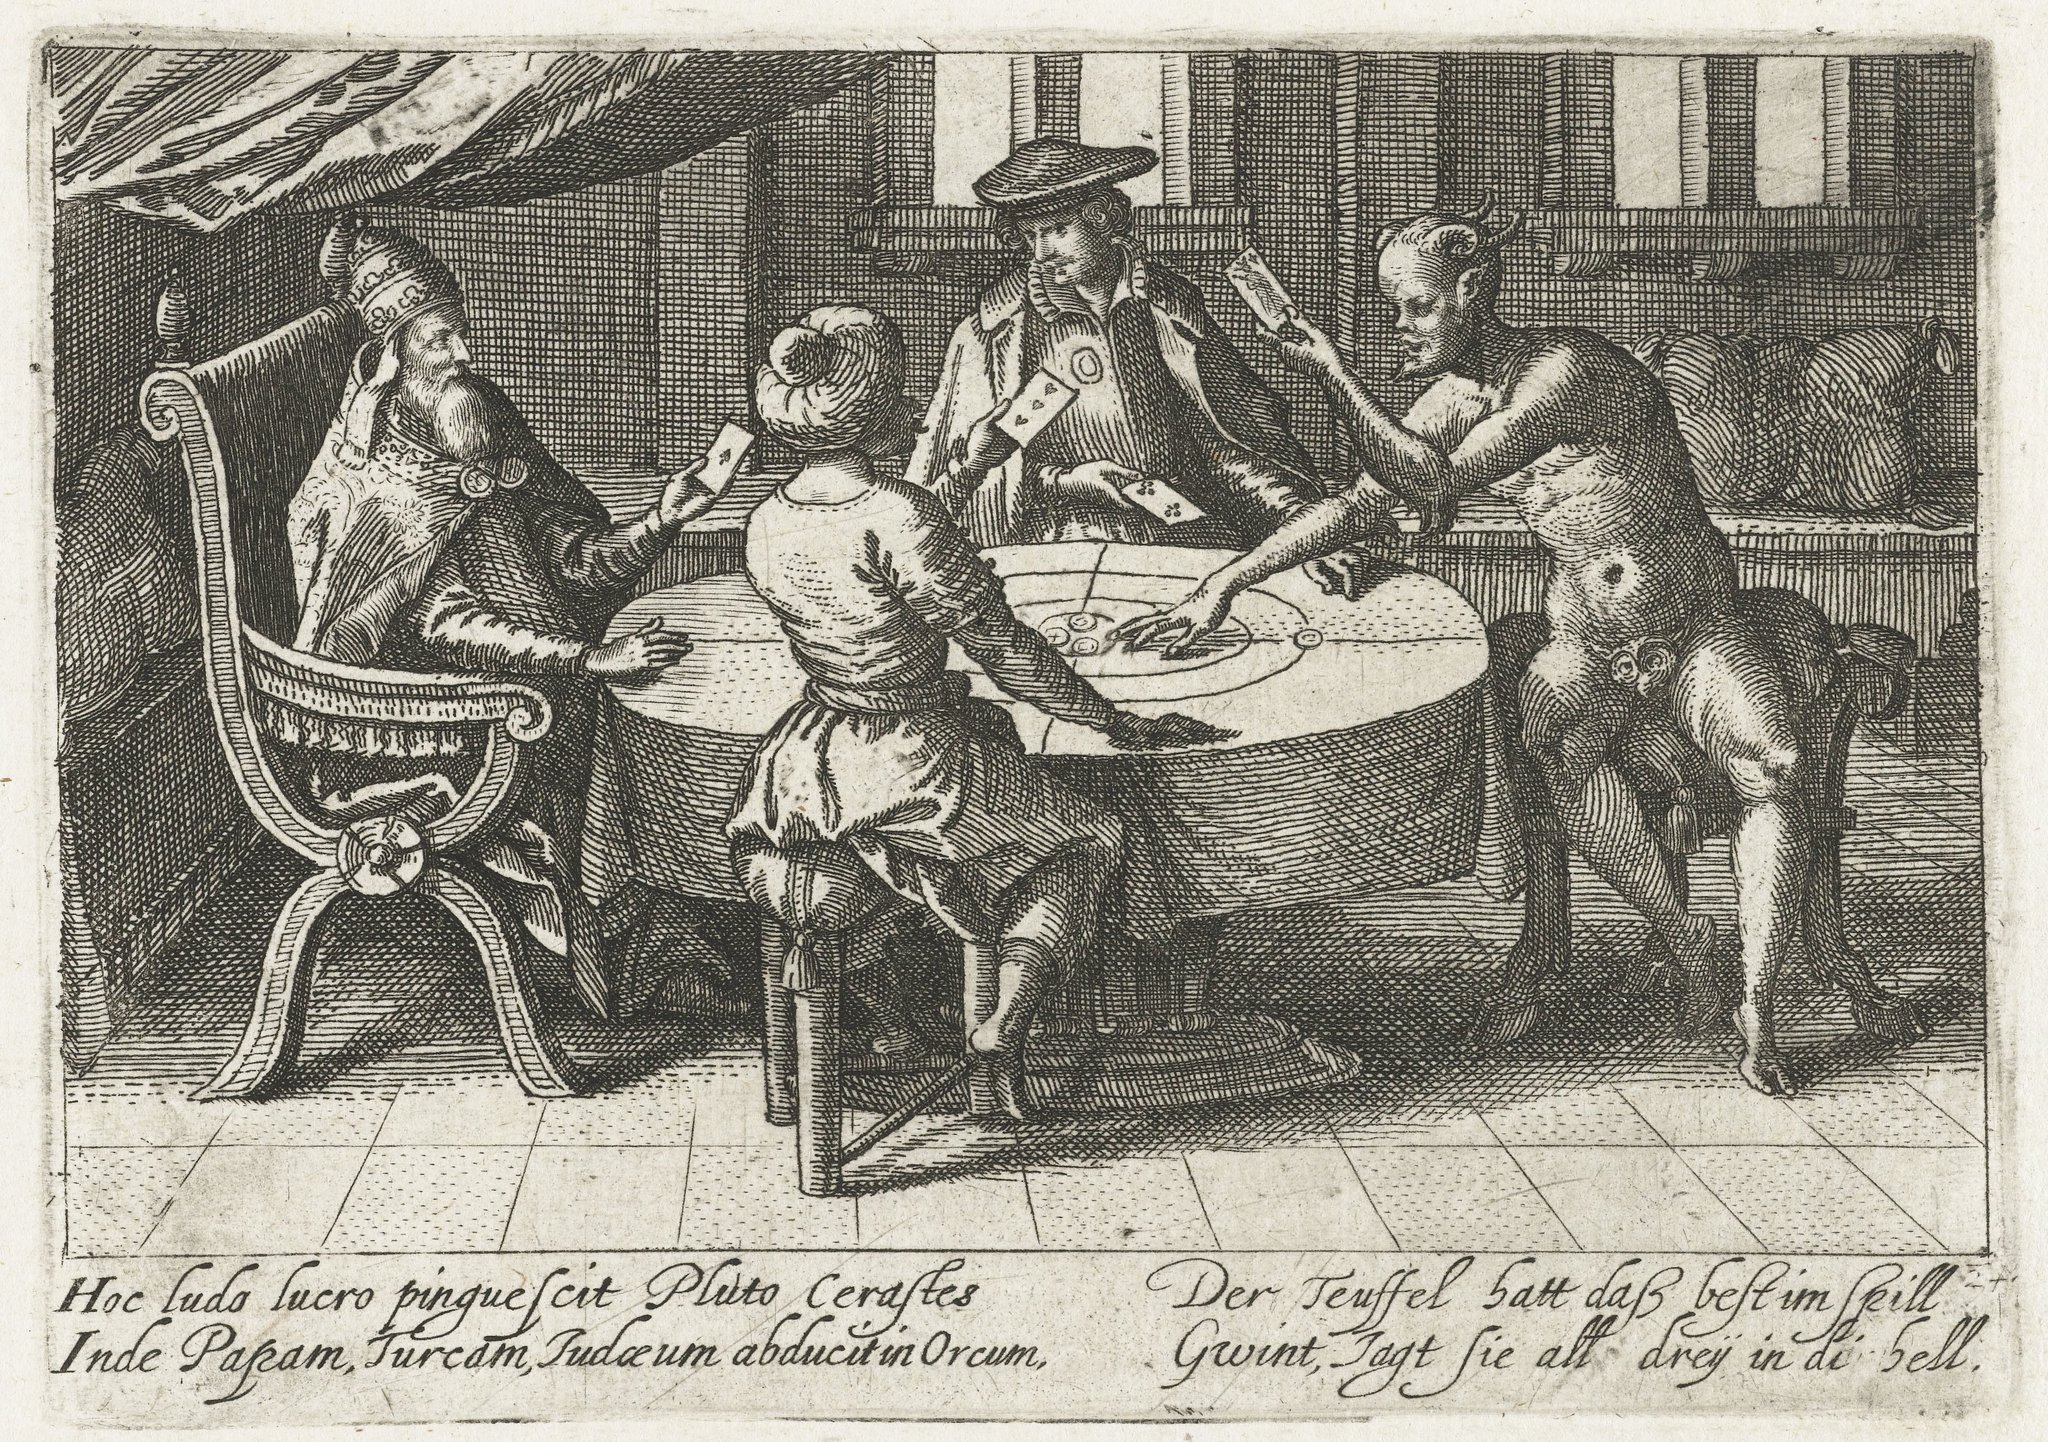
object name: print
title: Religieuze leiders kaarten met de Duivel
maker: jacob van der heyden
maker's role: draughtsman, print maker, publisher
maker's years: 1573-1645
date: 1608-1618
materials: paper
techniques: engraving, etching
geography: straatsburg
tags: priest ~ islam, mohammedanism, 'album amicorum', 'stammbuch', morality, card games, human-shaped devil, pope, priests ~ hierarchy of priests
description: Deze serie, getiteld ‘Pugillus facetiarum iconographicarum in studiosorum (…)’, bestond vermoedelijk uit 36 of meer prenten. Van deze serie zijn in ieder geval twee uitgaven bekend, uit 1608 en 1618. De prenten uit deze serie in de collectie van het Rijksmuseum (RP-P-1996-1 t/m RP-P-1996-36) zijn vermoedelijk afkomstig uit verschillende uitgaven, of uit de tweede uitgave. De inhoud van beide uitgaven verschilt, maar om de precieze inhoud van de verschillende uitgaven vast te stellen is meer onderzoek nodig. Er zijn geen volledige exemplaren van de eerste uitgave bekend. Aan de hand van de analyse van een andere serie, ‘Jeucht spieghel’,* die kopieën van ‘Pugillus’ bevat en is uitgegeven in 1610 én de aanwezige exemplaren van prenten uit ‘Pugillus’ in een inmiddels verloren album amicorum uit 1610,** kan in ieder geval van een aantal prenten gesteld worden dat ze al voorkwamen in de uitgave van 1608. Dit geldt voor RP-P-1996-1 (de titelprent), RP-P-1996-5, RP-P-1996-6, RP-P-1996-7, RP-P-1996-8, RP-P-1996-9, RP-P-1996-10, RP-P-1996-11, RP-P-1996-12, RP-P-1996-13, RP-P-1996-14, RP-P-1996-15, RP-P-1996-16, RP-P-1996-17, RP-P-1996-18, RP-P-1996-19, RP-P-1996-24, RP-P-1996-28, RP-P-1996-29, RP-P-1996-33 en RP-P-1996-35. Van één prent (RP-P-1996-31) kan vastgesteld worden dat die pas in de latere uitgave van 1618 voorkwam, omdat het kopie is van een prent uit weer een andere serie, ‘Academia sive speculum vitae scholasticae (…)’, die werd uitgegeven in 1612.*** Deze prent kwam al voor in de uitgave van 1608. Dit blijkt uit het album amicorum.** * Z.G.H.P.H.S [Zacharias Heyns]. Jeucht spieghel. S.l.s.n., 1610. Voor een gedigitaliseerd exemplaar zie: https://archive.org/details/ned-kbn-all-00000628-001/page/n9/mode/2up. ** Zie: Erman, Wilhelm en Ewald Horn. Bibliographie der deutschen Universitäten, systematisch geordnetes Verzeichnis der bis Ende 1899 gedruckten Bücher und Aufsätze über das deutsche Universitätswesen. Leipzig en Berlijn: Verlag von B.G. Teubner, 1904, dl. 1, p. 826-832, no. 17328. https://archive.org/details/bibliographieder01ermauoft/page/826/mode/2up *** Passe, Crispijn van de (I). Academia sive speculum vitae scholasticae (…). Arnhem: Johannes Janssonius [Jan Jansz.], 1612. Voor een gedigitaliseerd exemplaar zie: http://gallica.bnf.fr/ark:/12148/btv1b55005974h.